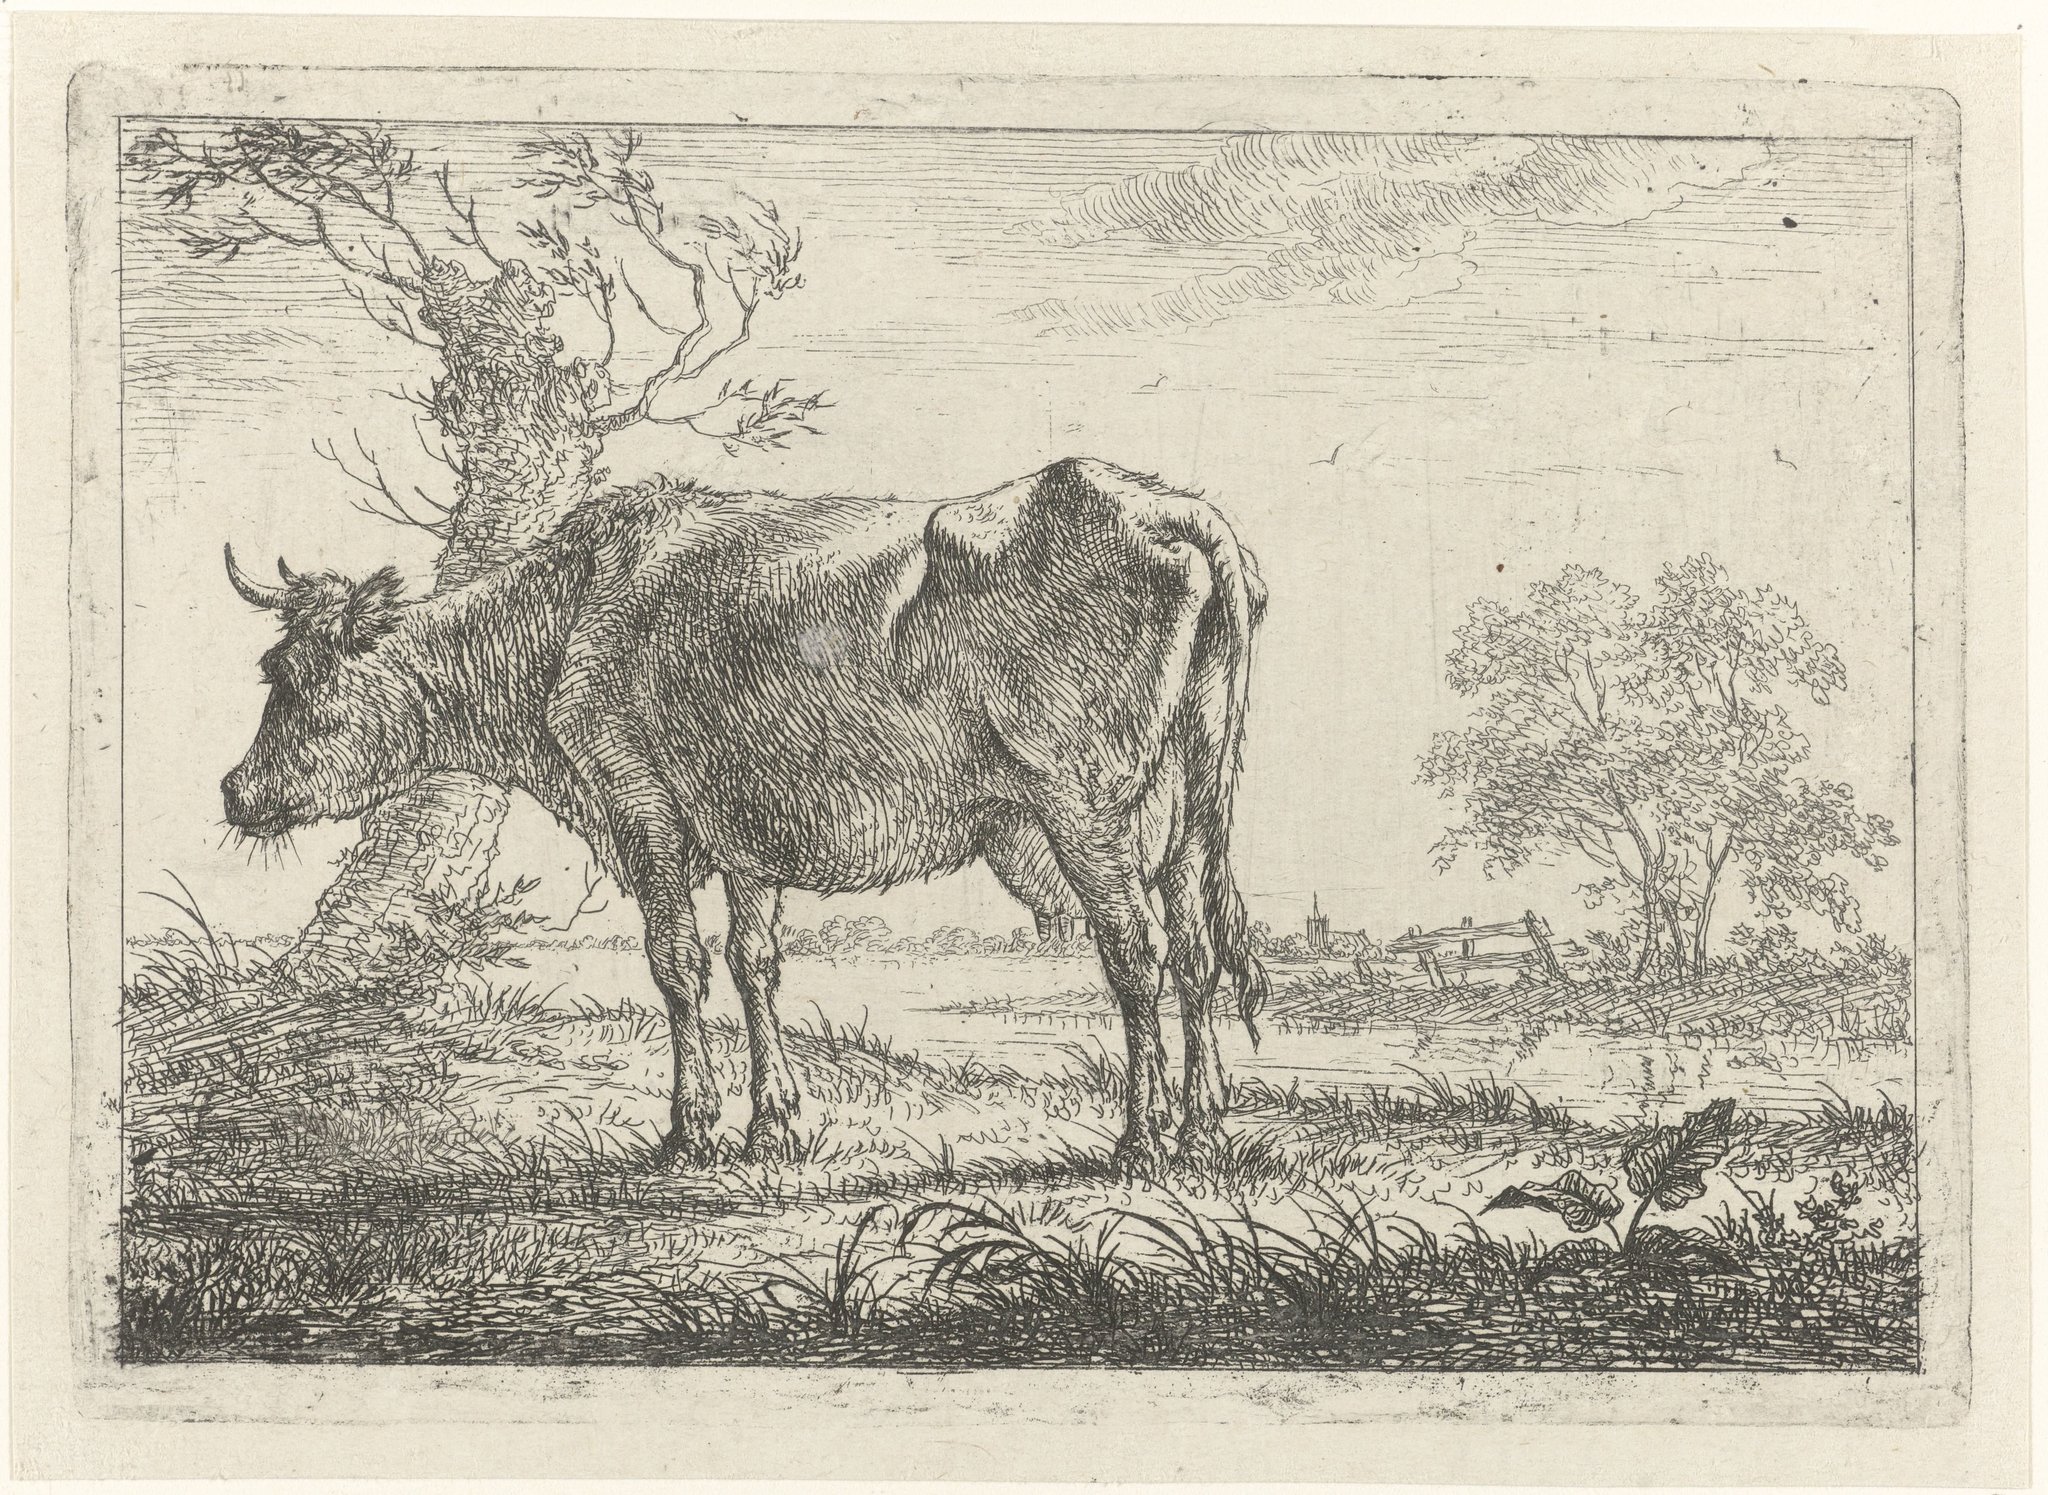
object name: print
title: Staande koe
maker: johannes janson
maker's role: draughtsman, painter, print maker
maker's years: 1729-1784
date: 1761-1784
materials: paper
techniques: etching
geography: leiden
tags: cow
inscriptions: collector's mark: Lugt 240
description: Weiland met staande koe, van opzij gezien. Prent uit een serie met landschappen met vee.